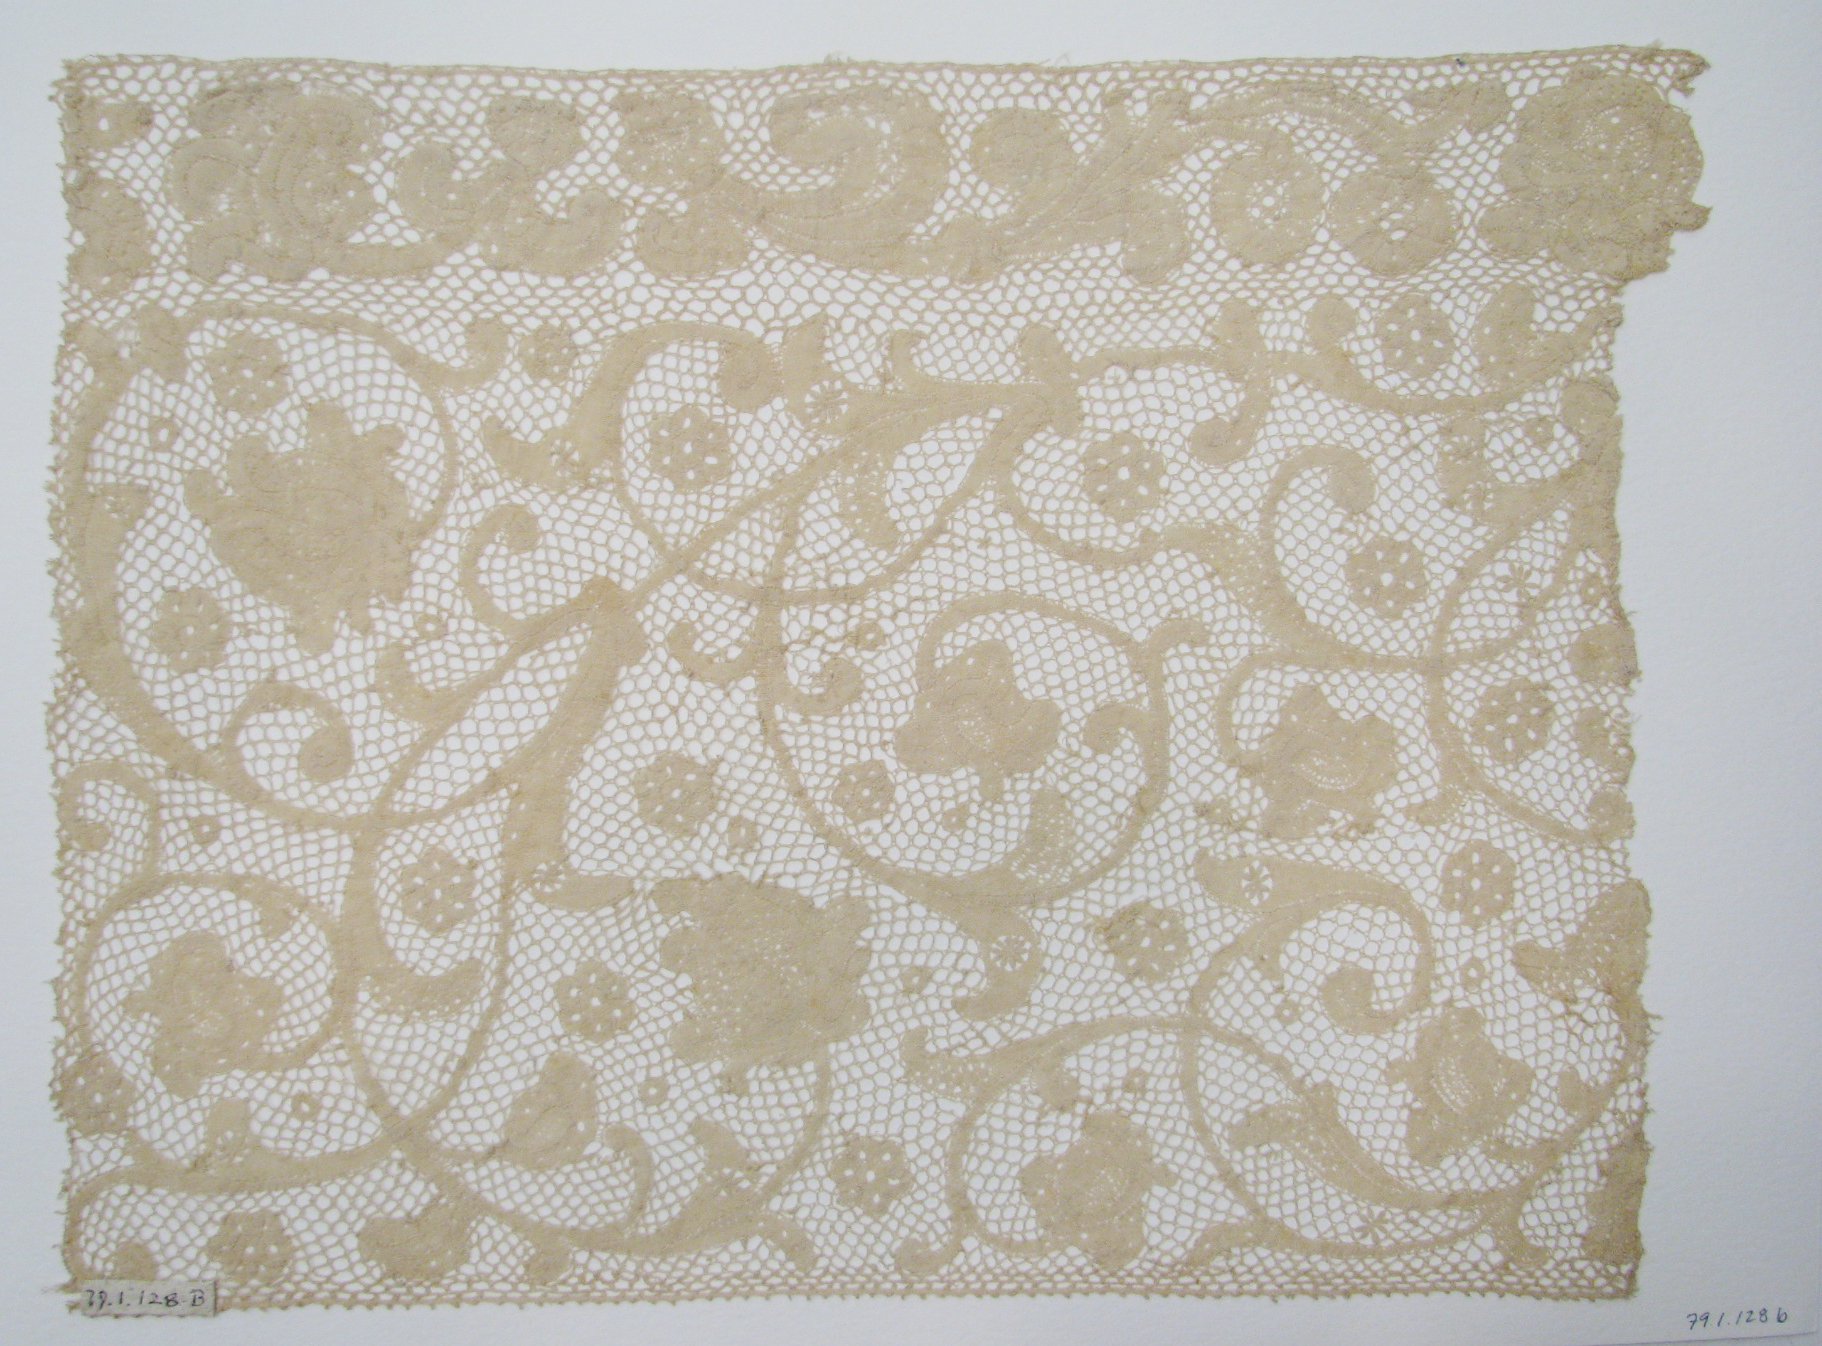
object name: fragment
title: Fragment of Point de Milan lace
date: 1601-1800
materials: lace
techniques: lace